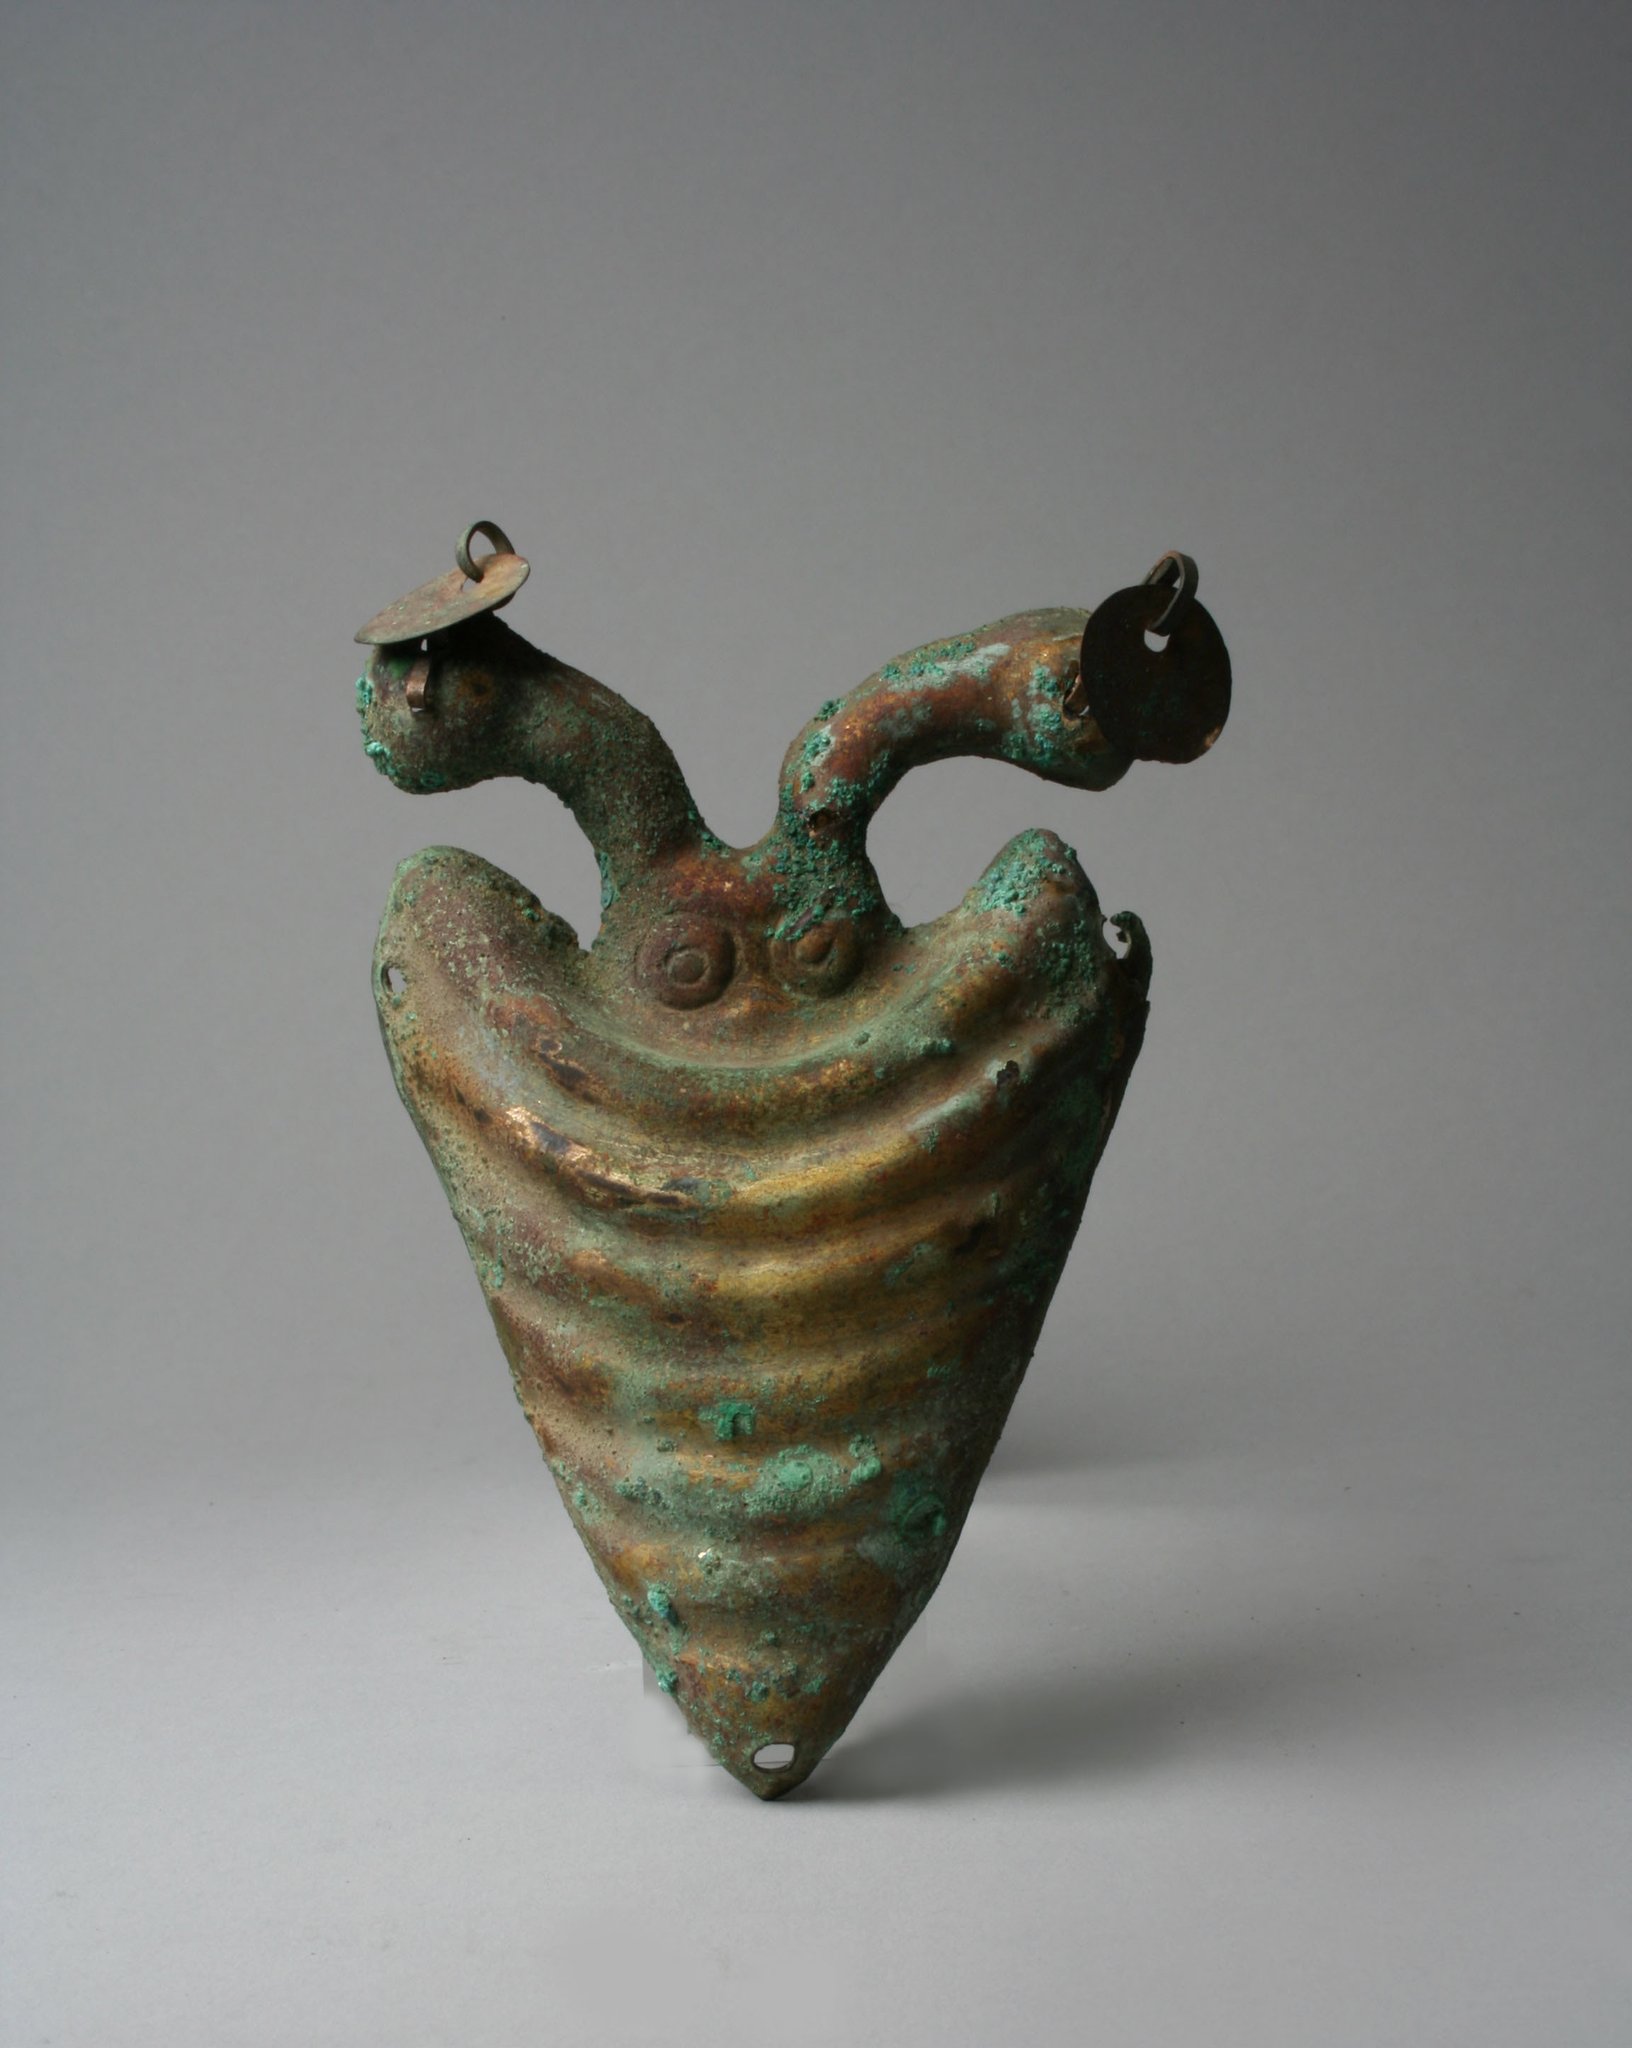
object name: ornament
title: Animal Ornament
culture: moche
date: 501-700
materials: gilt copper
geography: peru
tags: animals